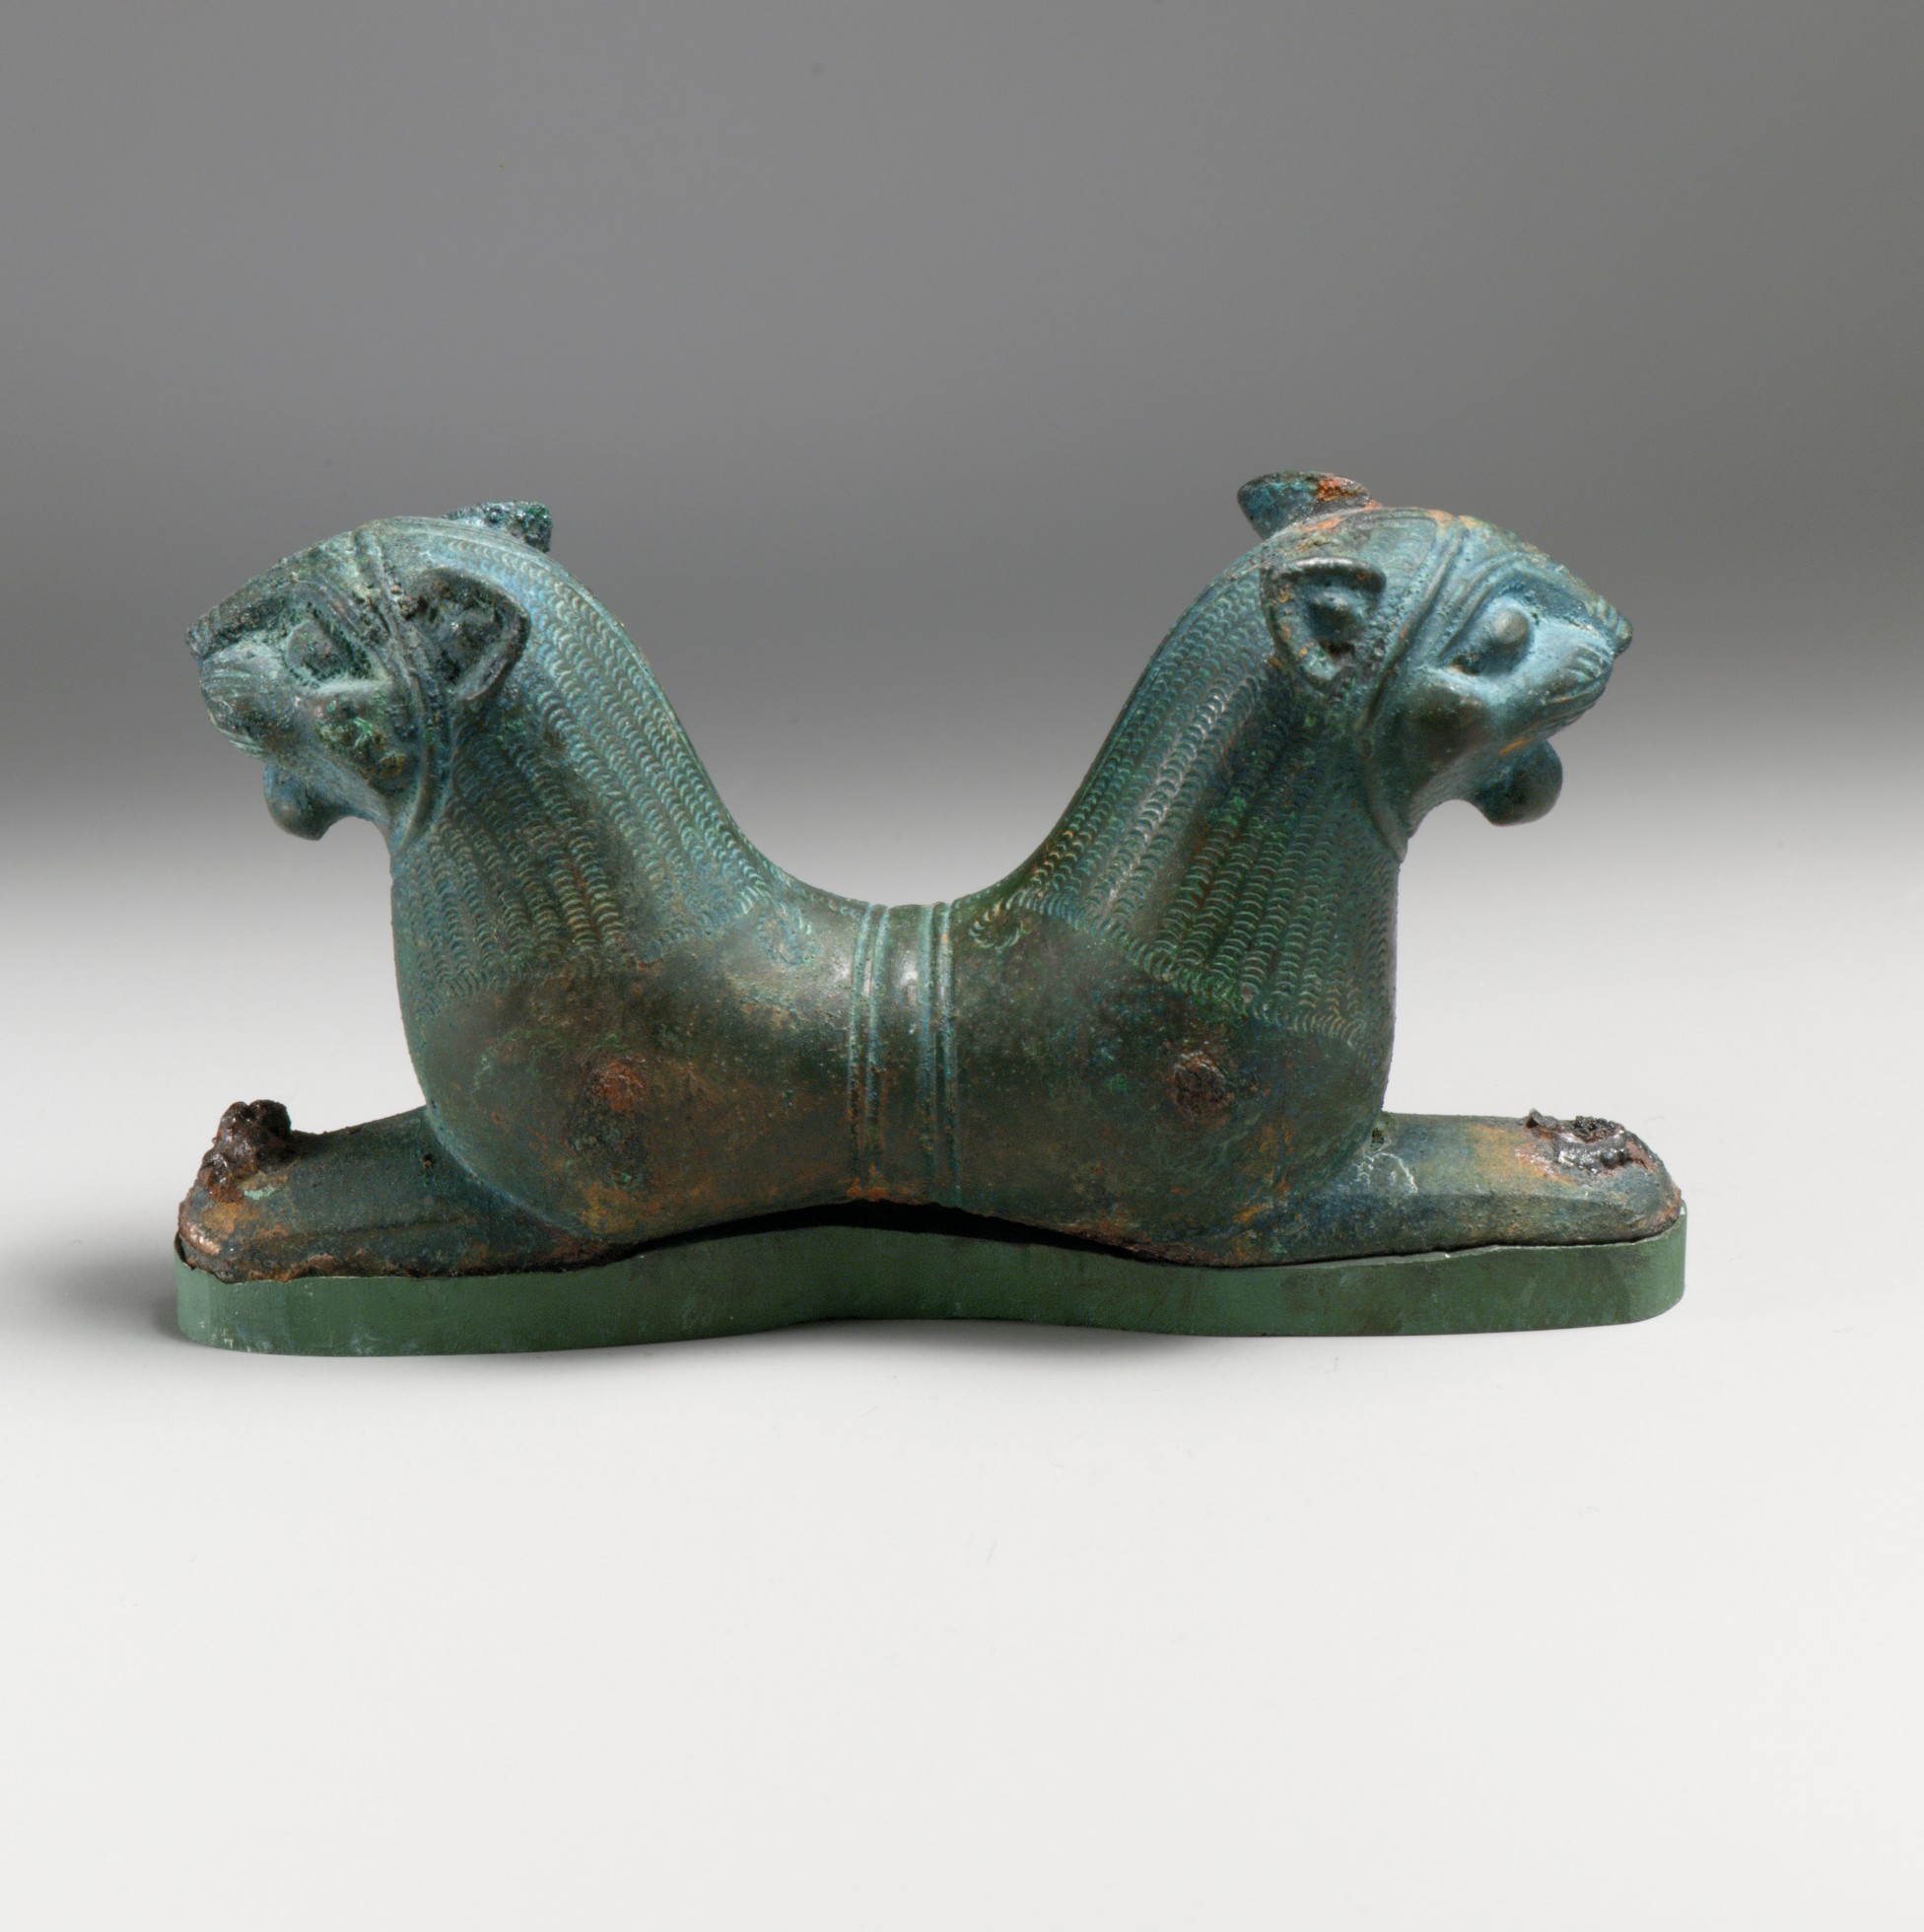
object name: statuette of a lion, two joined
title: Bronze statuette of a double-headed lion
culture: etruscan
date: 550-500 BCE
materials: bronze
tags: lions